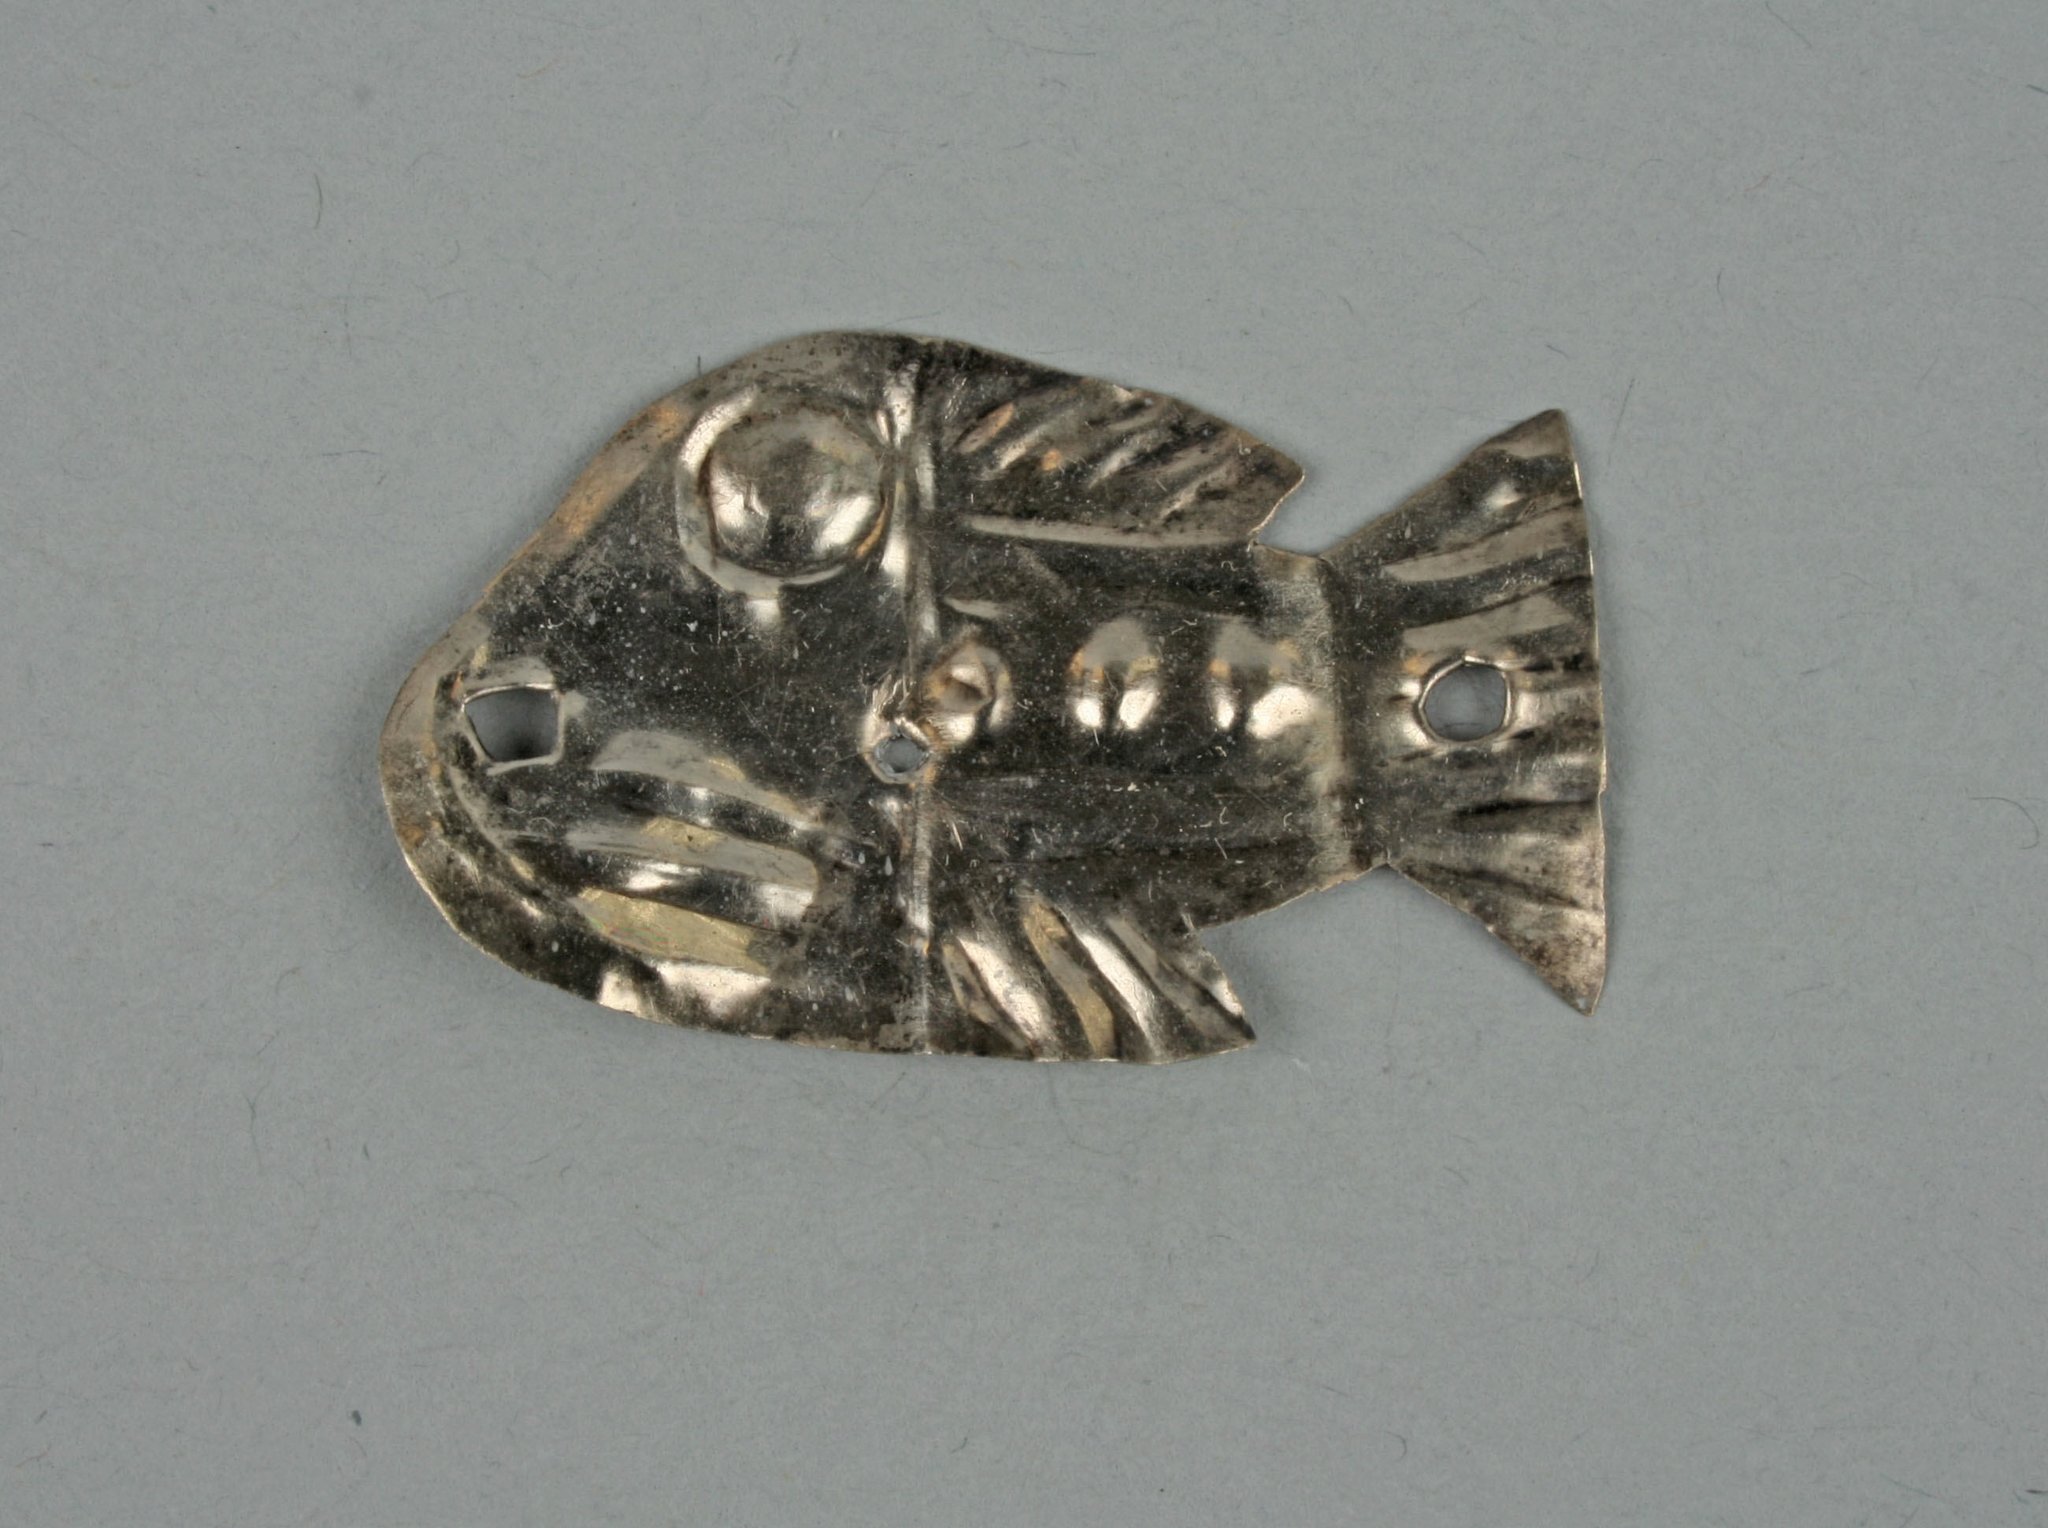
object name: ornament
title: Fish Ornament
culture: peruvian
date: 1001-1200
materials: silver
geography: peru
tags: fish